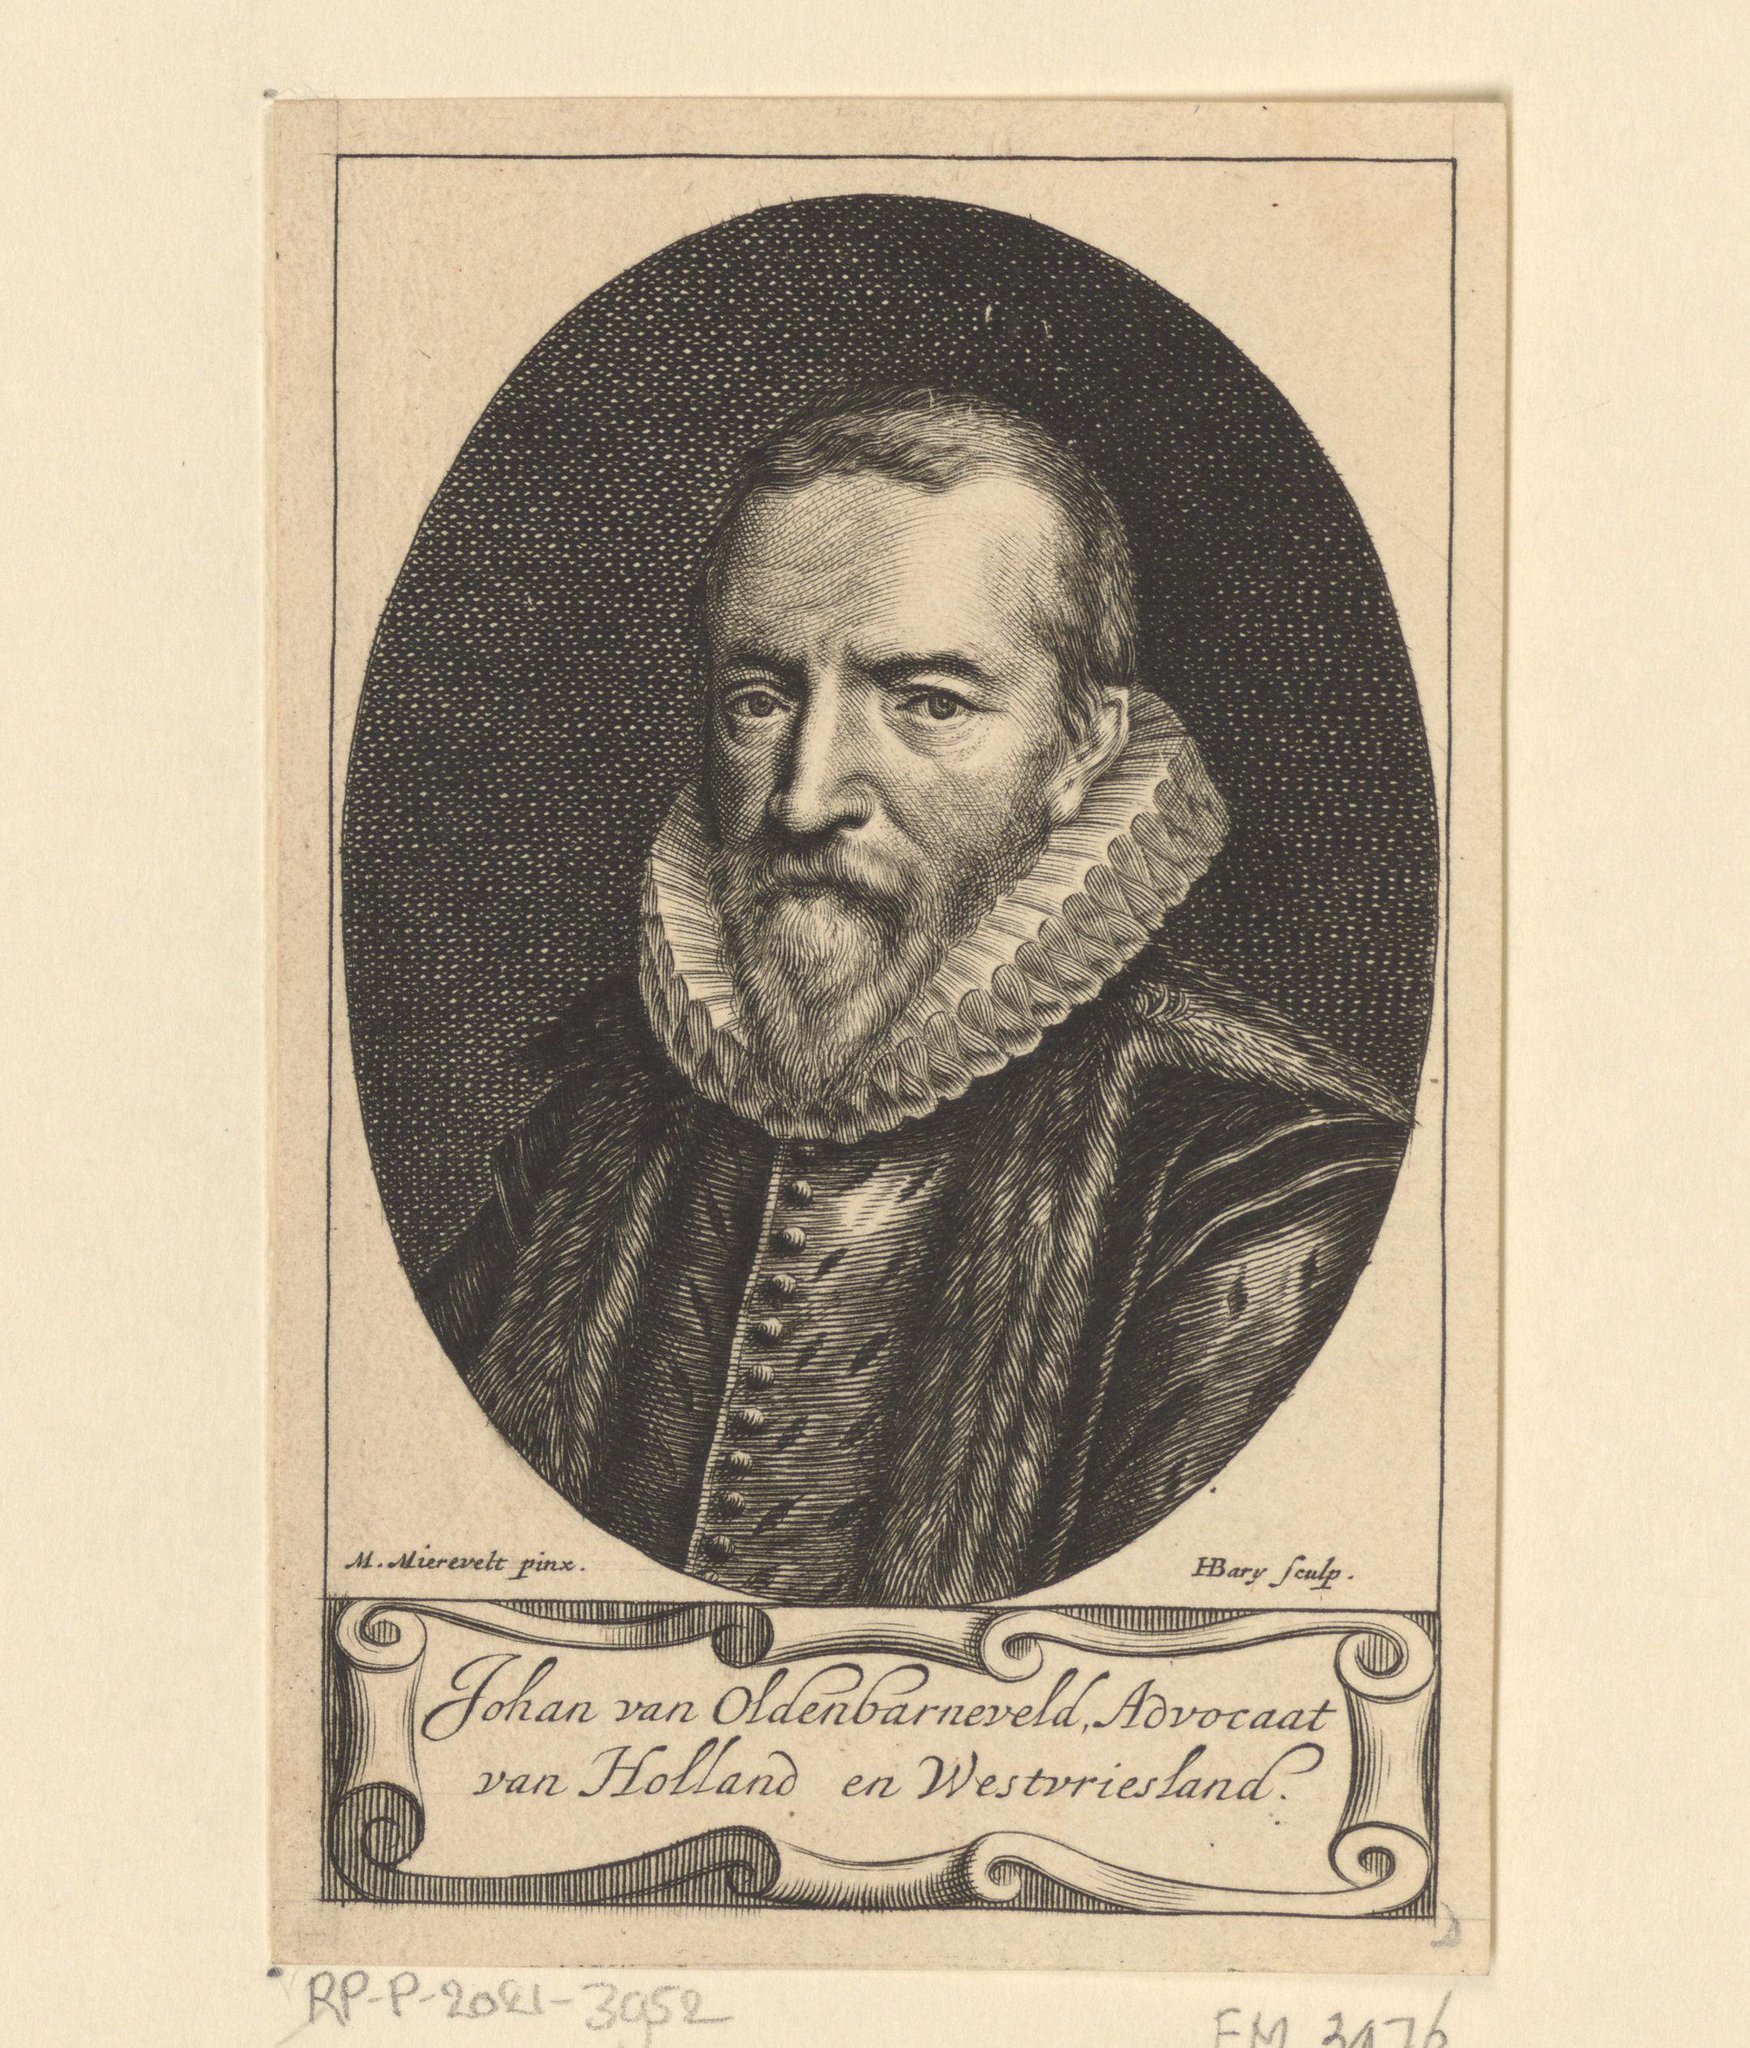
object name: print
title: Portret van Johan van Oldenbarnevelt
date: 1670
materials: paper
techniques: engraving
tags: johan van oldenbarnevelt, historical persons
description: Prent mogelijk uit: Waaragtige historie van I. van Oldenbarneveld. Rotterdam: Joannes Naeranus, 1670.